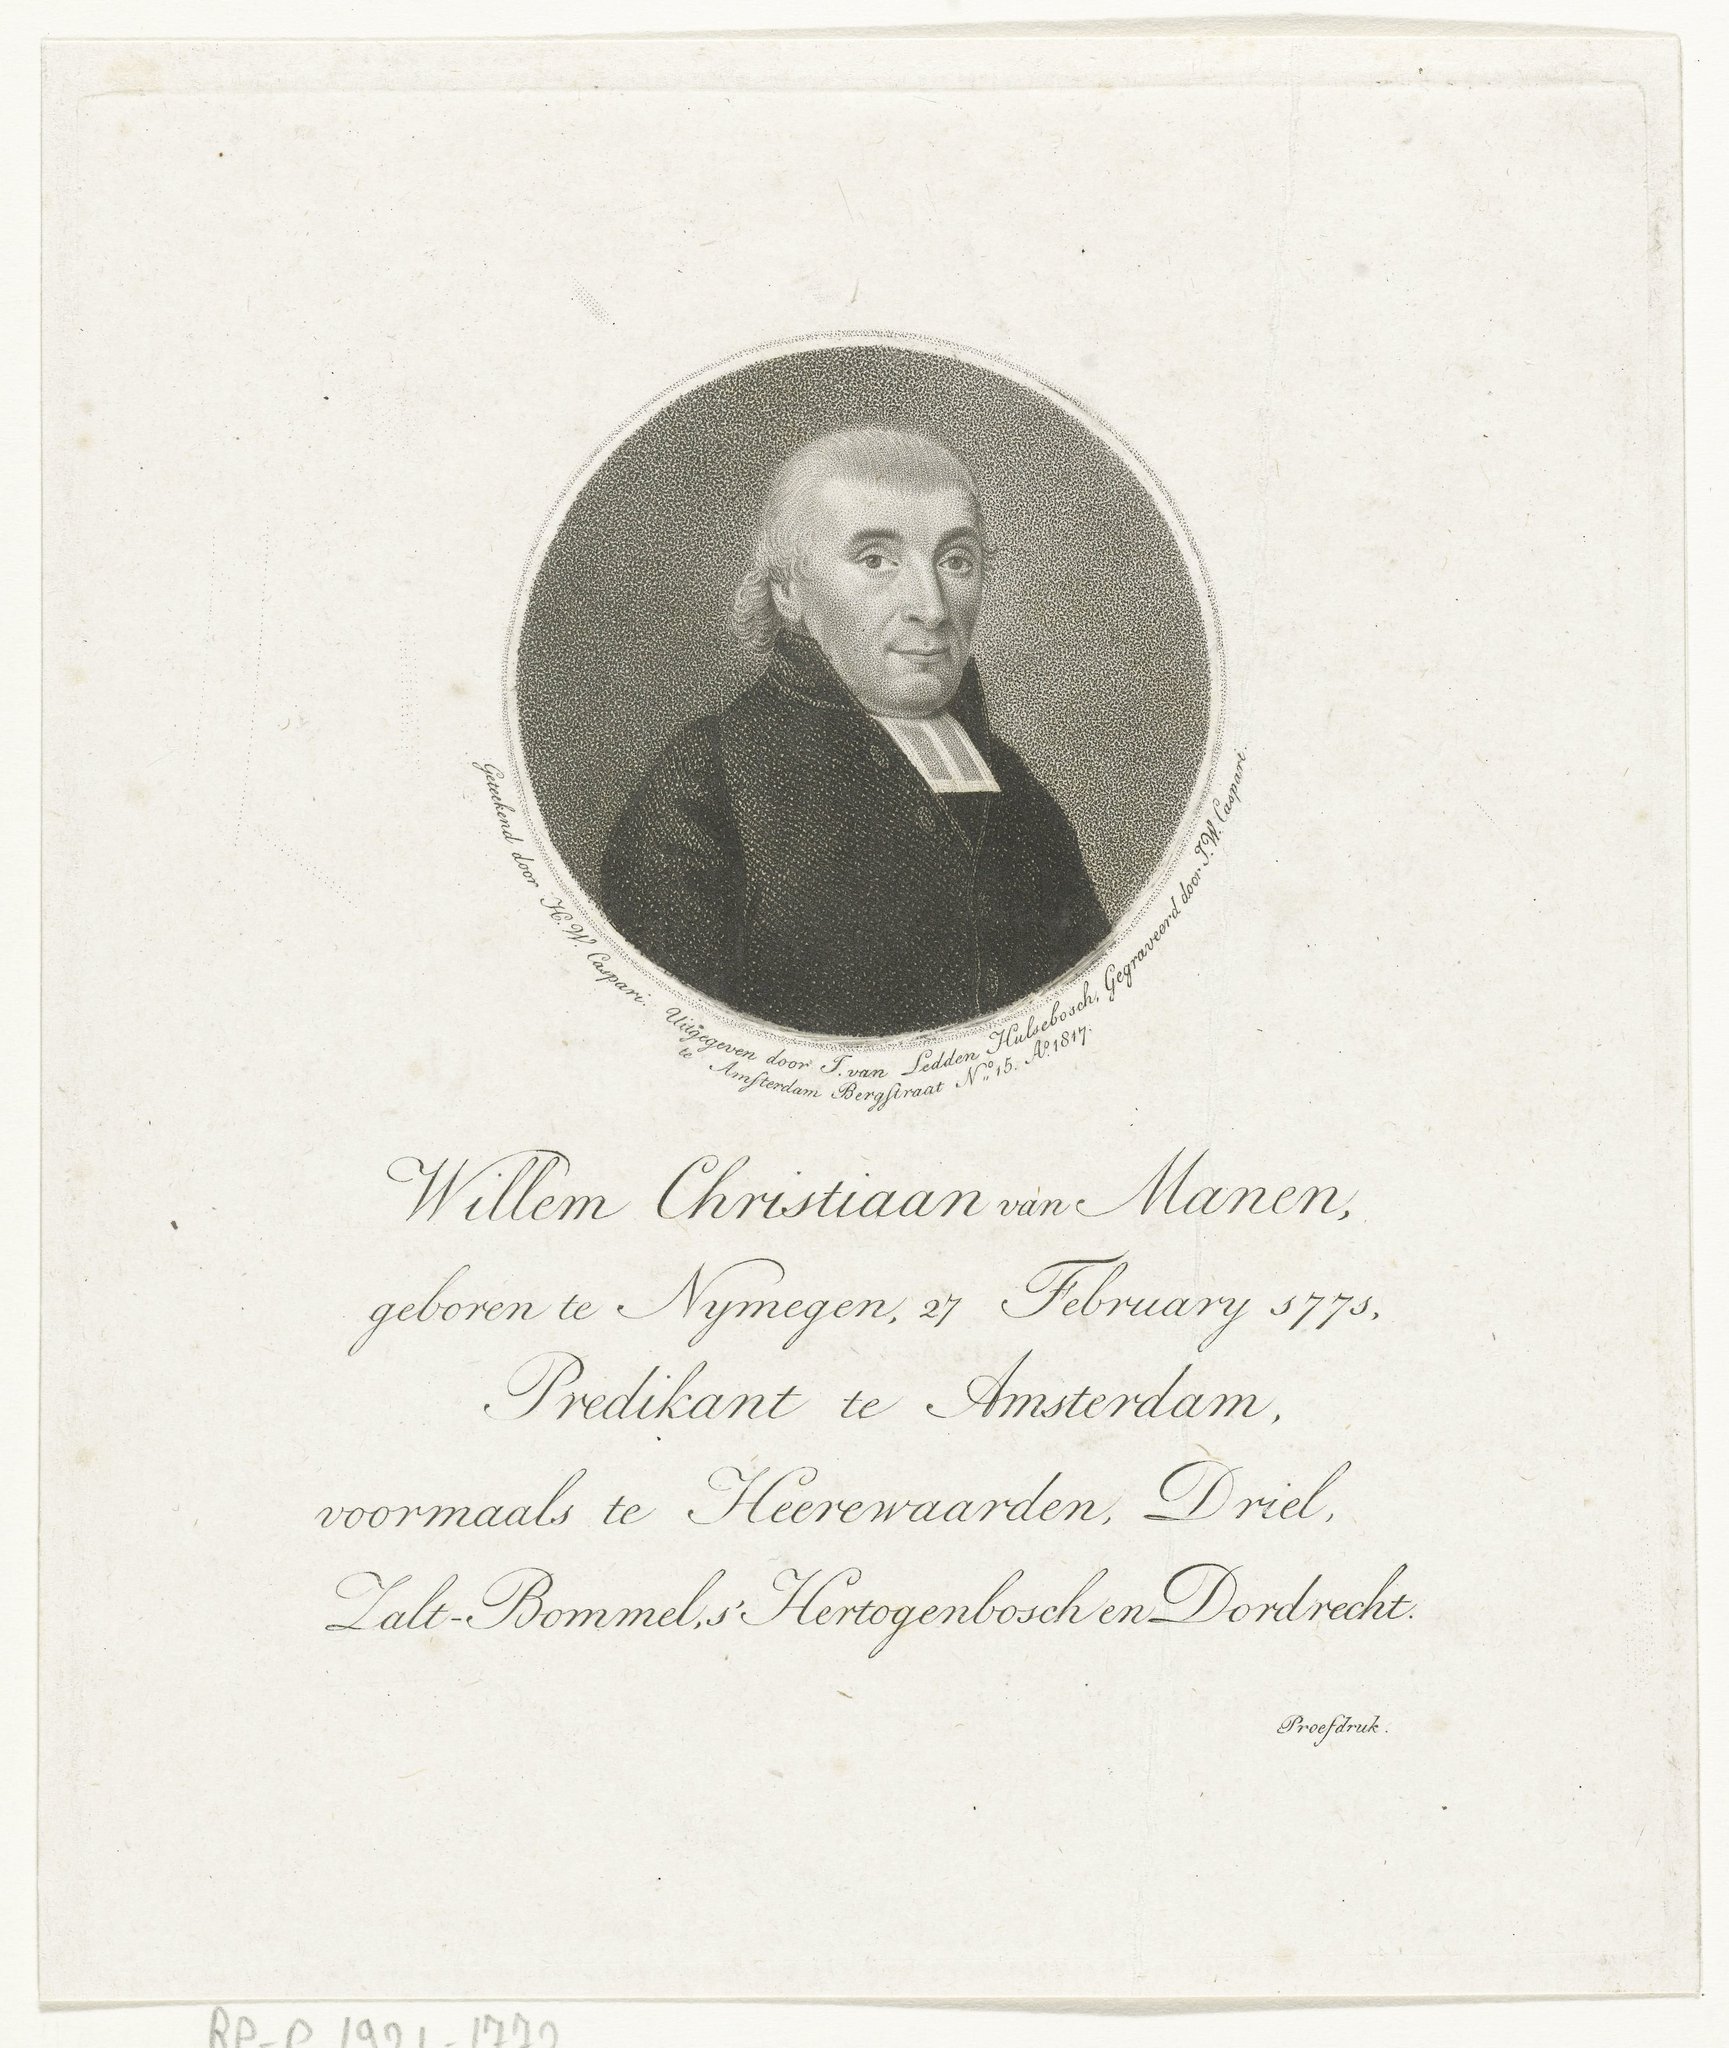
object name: print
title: Portret van Willem Christiaan van Manen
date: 1817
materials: paper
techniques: etching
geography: amsterdam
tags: willem christiaan van manen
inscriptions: inscription: ‘proefdruk’, collector's mark: Lugt 2233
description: Portret van Willem Christiaan van Manen, Predikant van Heerenveen, Zaltbommel, 's Hertogenbosch en Amsterdam. Buste naar rechts. Van Manen heeft een zwarte jas aan en draagt een witte bef. De prent heeft een Nederlands onderschrift met de naam van de geportretteerde.